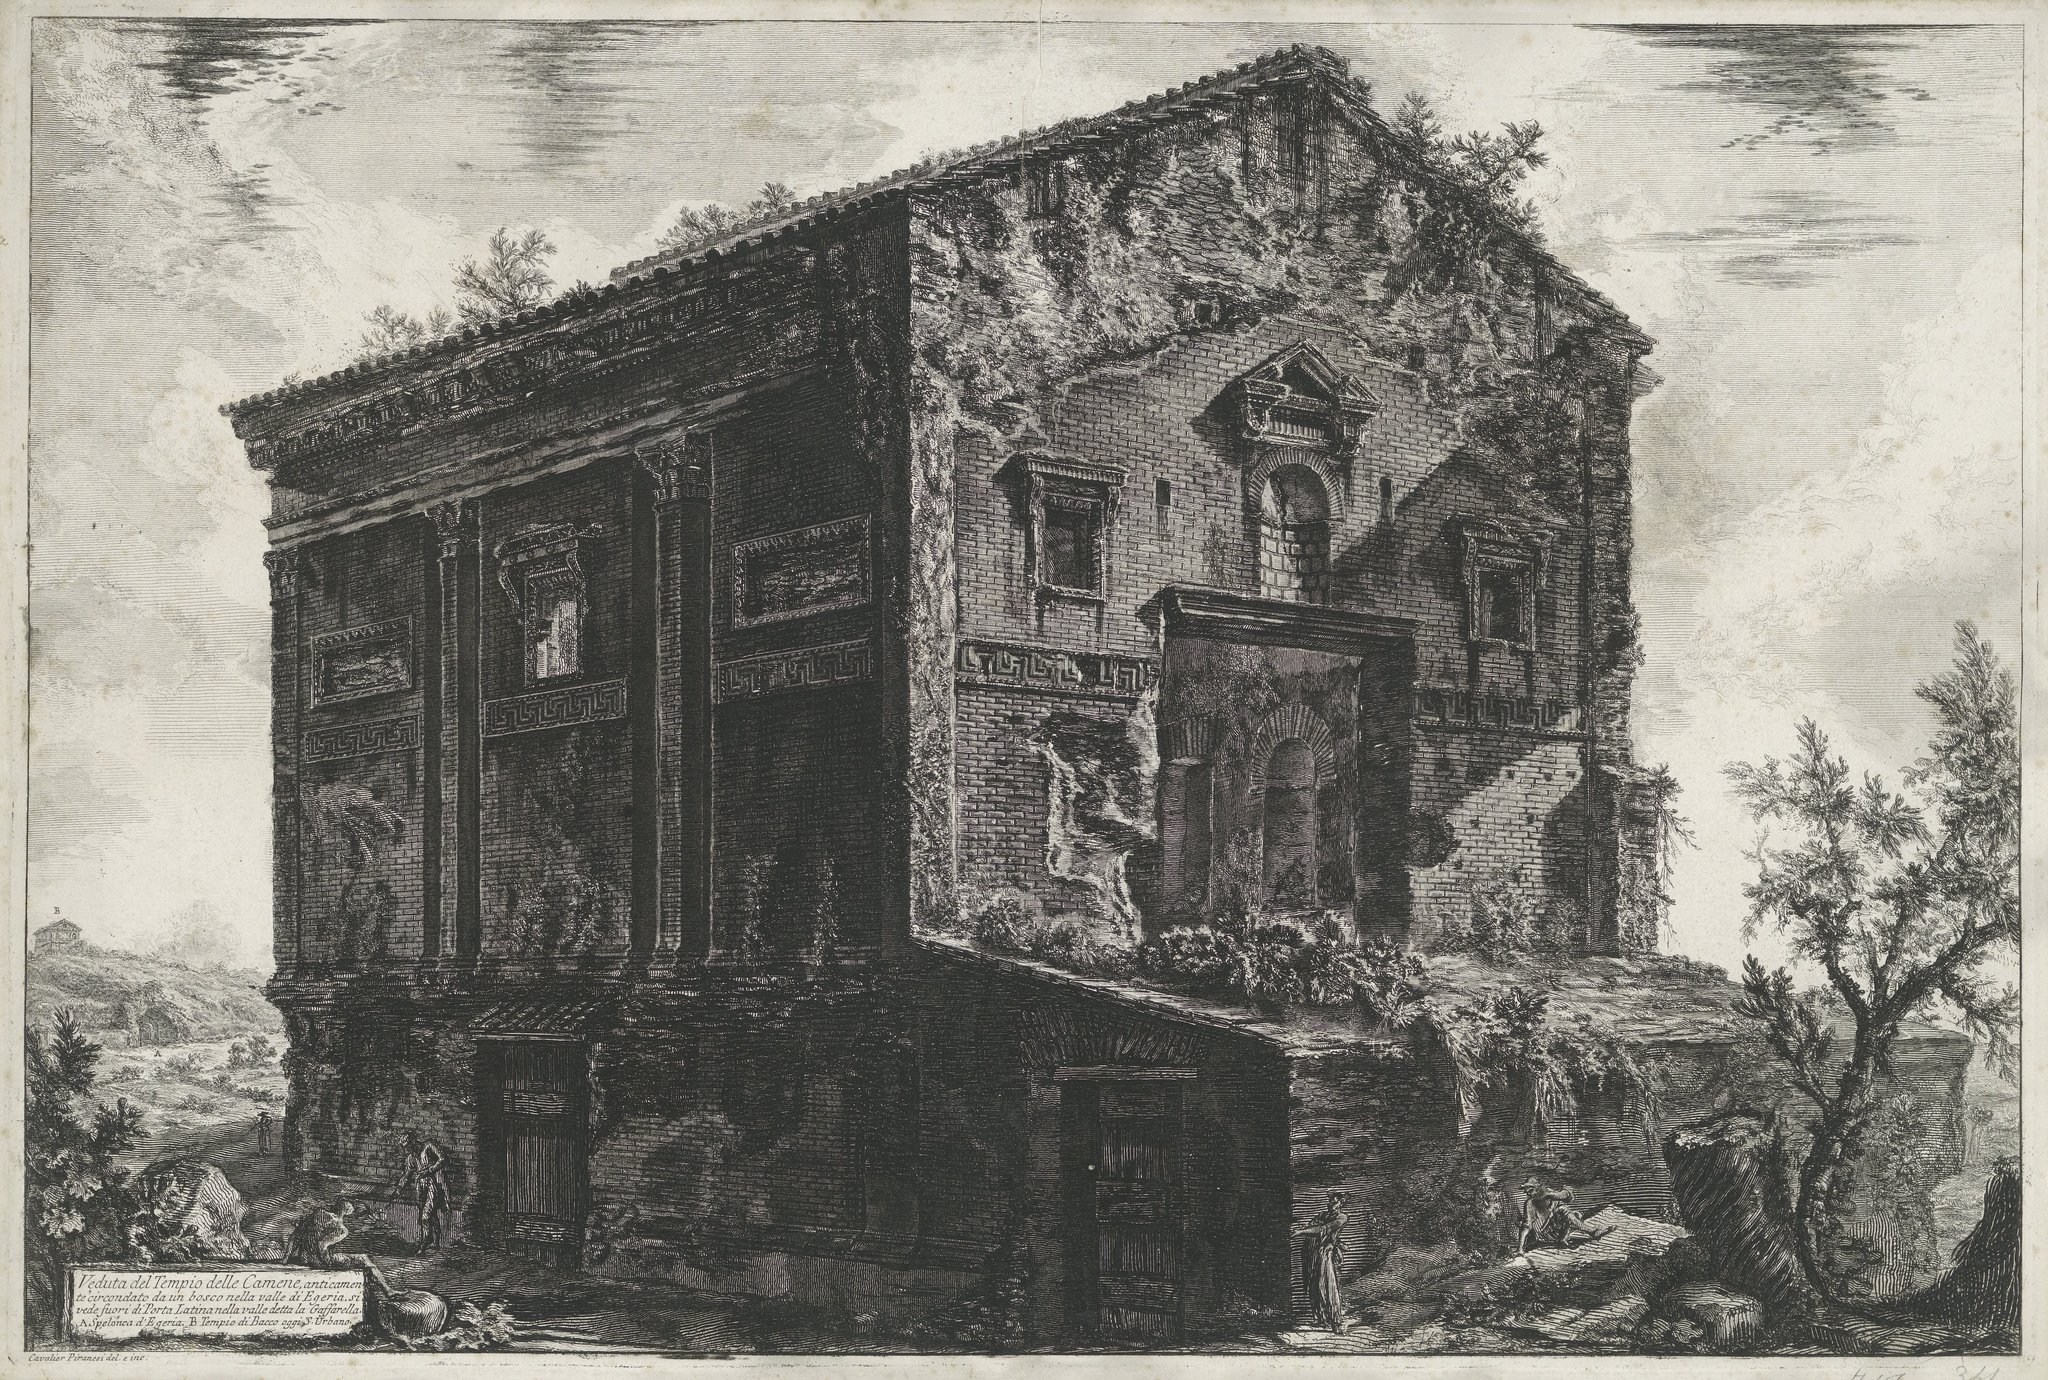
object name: print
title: Vedute di Roma disegnate ed incise da Giambattista Piranesi architetto Ve(nez)iano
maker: giovanni battista piranesi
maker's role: designer, draughtsman, print maker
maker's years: 1720-1778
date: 1748-1778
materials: paper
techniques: etching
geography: rome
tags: city-view, and landscape with man-made constructions, landscape with ruins, grave, tomb, rome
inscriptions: collector's mark: Lugt 2228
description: Deze prent maakt deel uit van de serie 'Vedute di Roma'. Piranesi werkte aan deze 135 platen tellende serie tussen 1748 en zijn dood in 1778. Francesco Piranesi voegde later nog twee prenten toe aan de reeks van zijn vader.